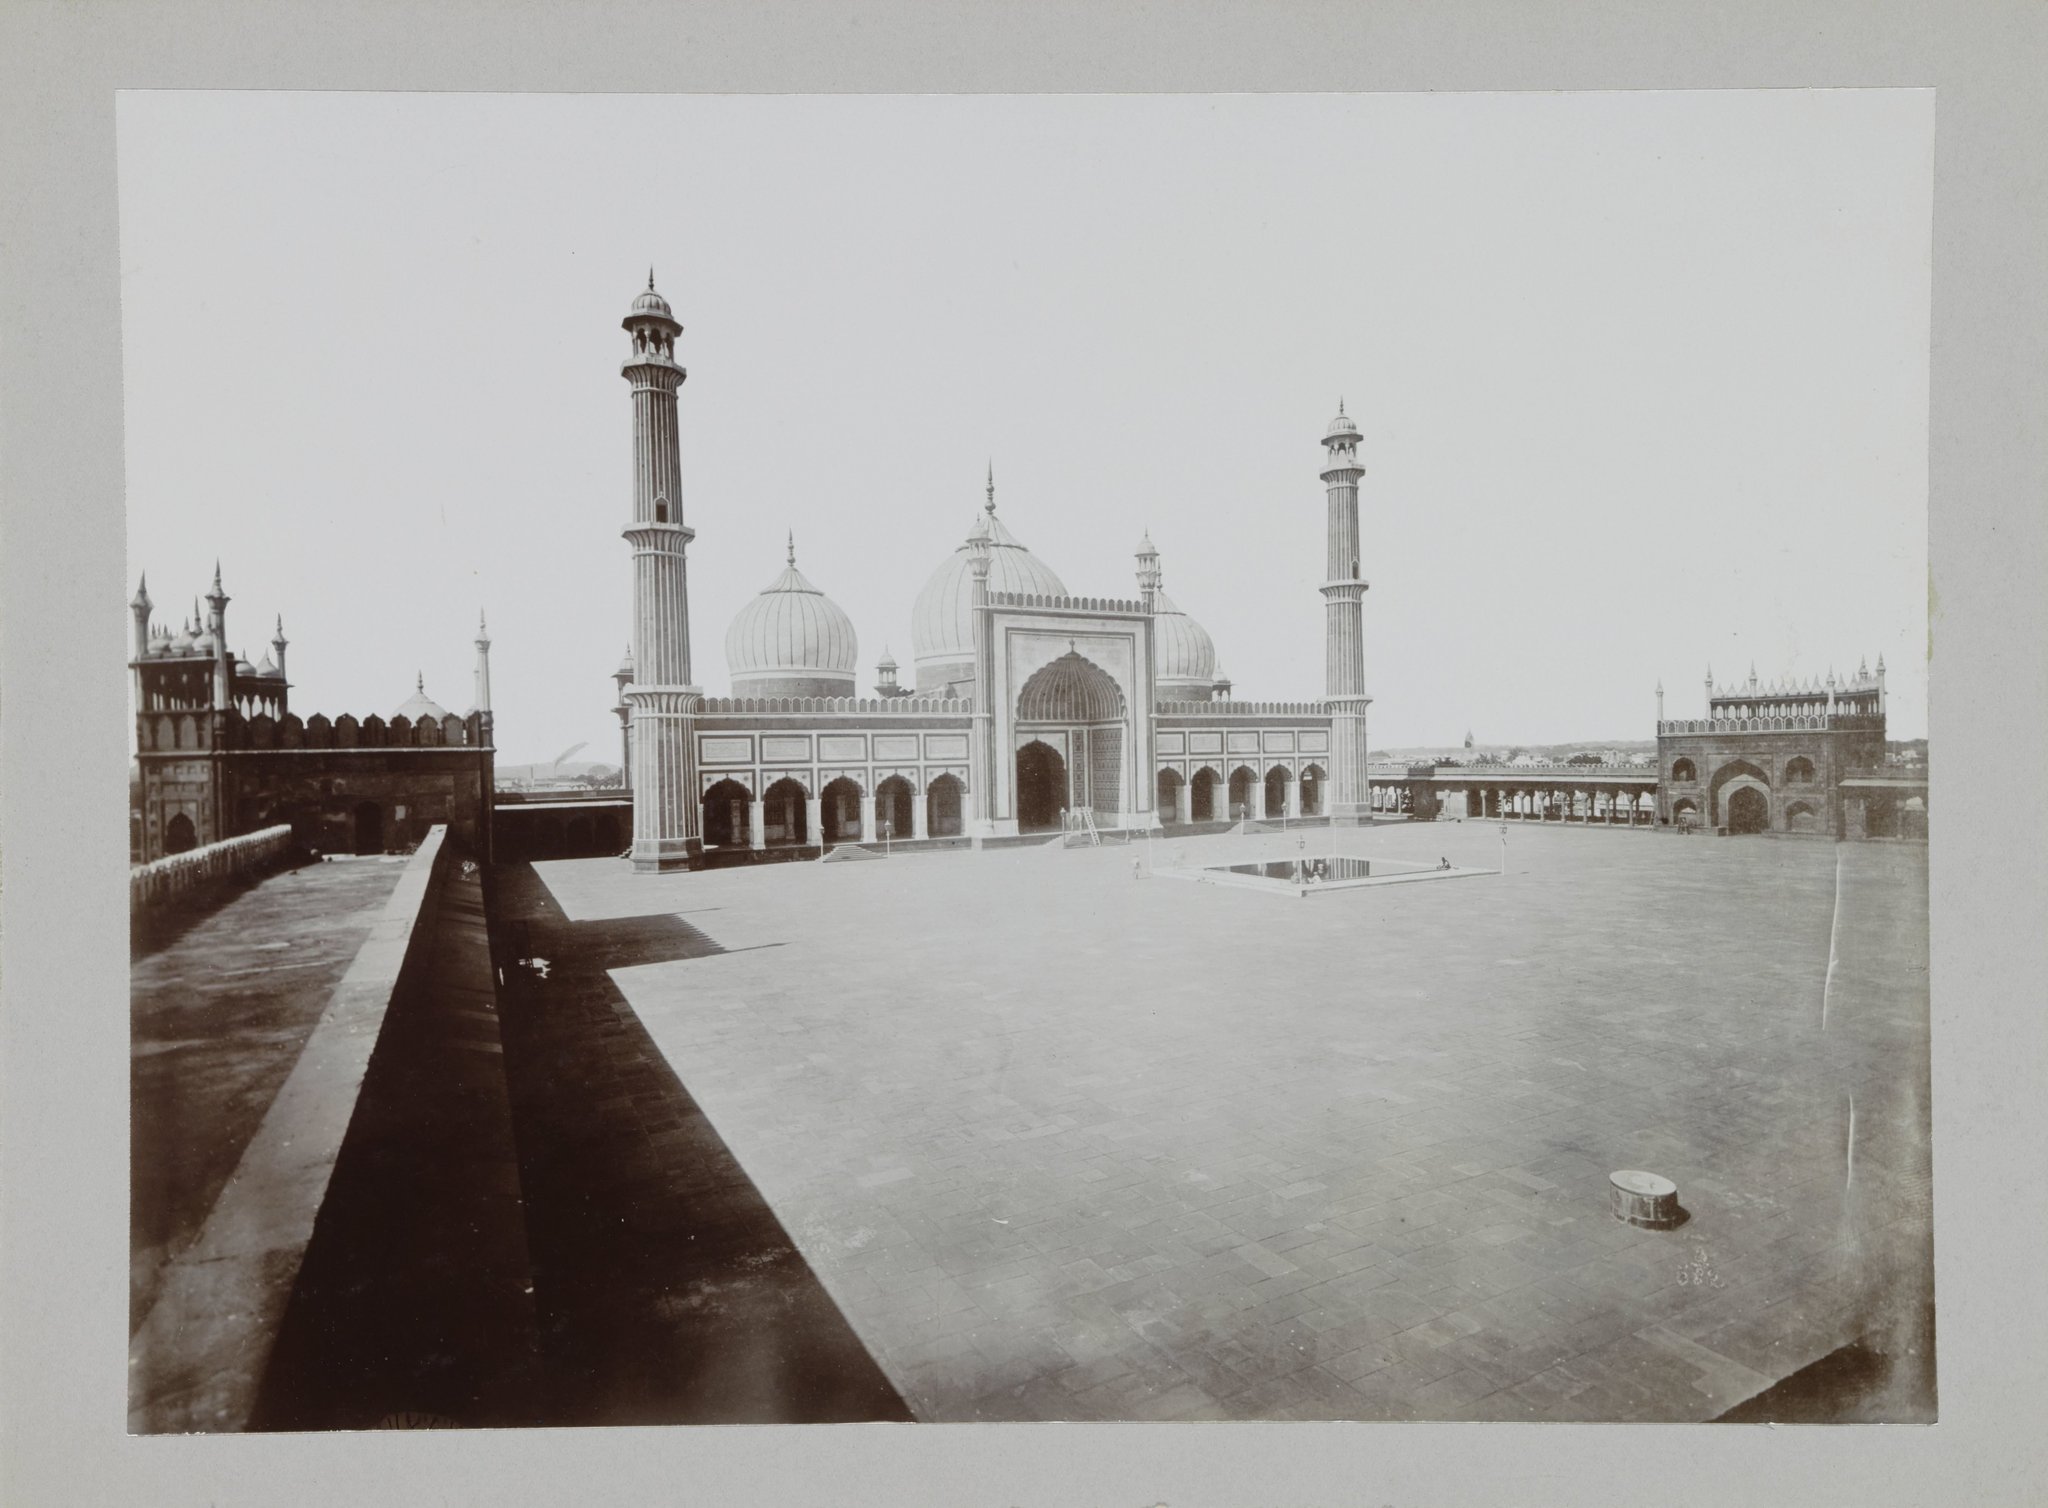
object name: photograph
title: View of the Jama Masjid in Delhi, India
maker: Anonymous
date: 1895-1915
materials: cardboard, paper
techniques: gelatin silver print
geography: delhi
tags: delhi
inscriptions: annotation: ‘20. Moskee te Delhi.’